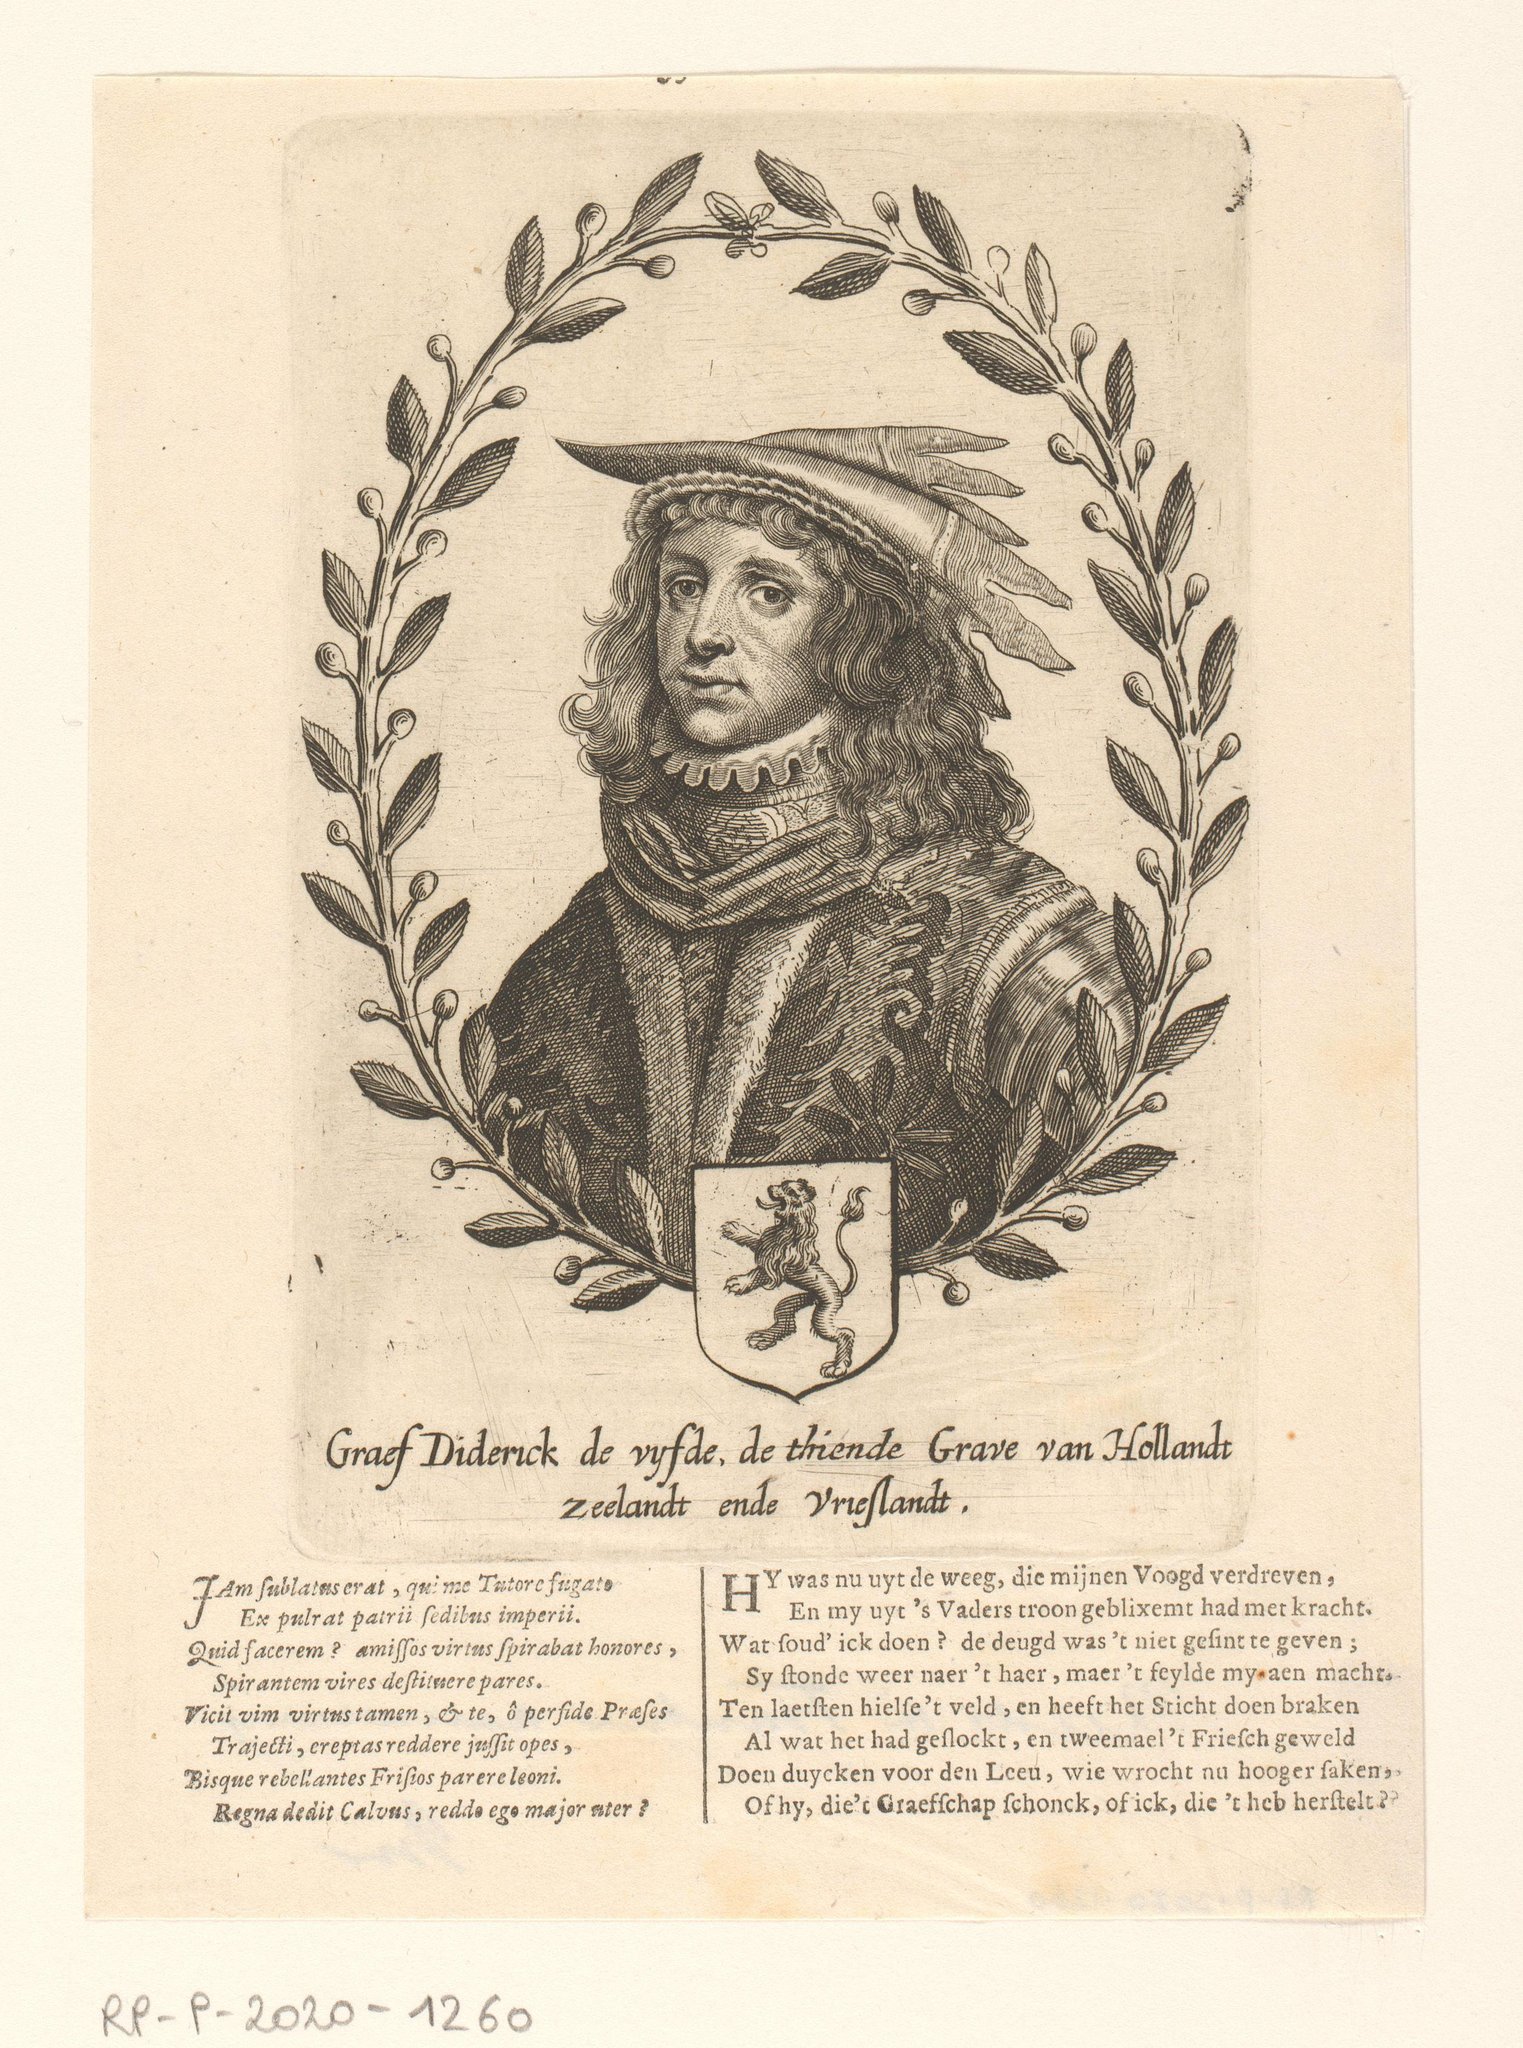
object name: book illustration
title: Graef Diderick de vijfde, de thiende grave von Hollandt Zeelandt ende Vrieslandt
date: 1677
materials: paper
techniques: engraving, etching, letterpress printing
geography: the hague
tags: earl, historical persons, ruler, sovereign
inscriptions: collector's mark: Lugt 964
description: Prent uit: Scriverius, Petrus. Hollandsche, Zeelandsche ende Vriesche chronyck. Den Haag: Jasper Doll en Johan Veely, 1677, p. 105.